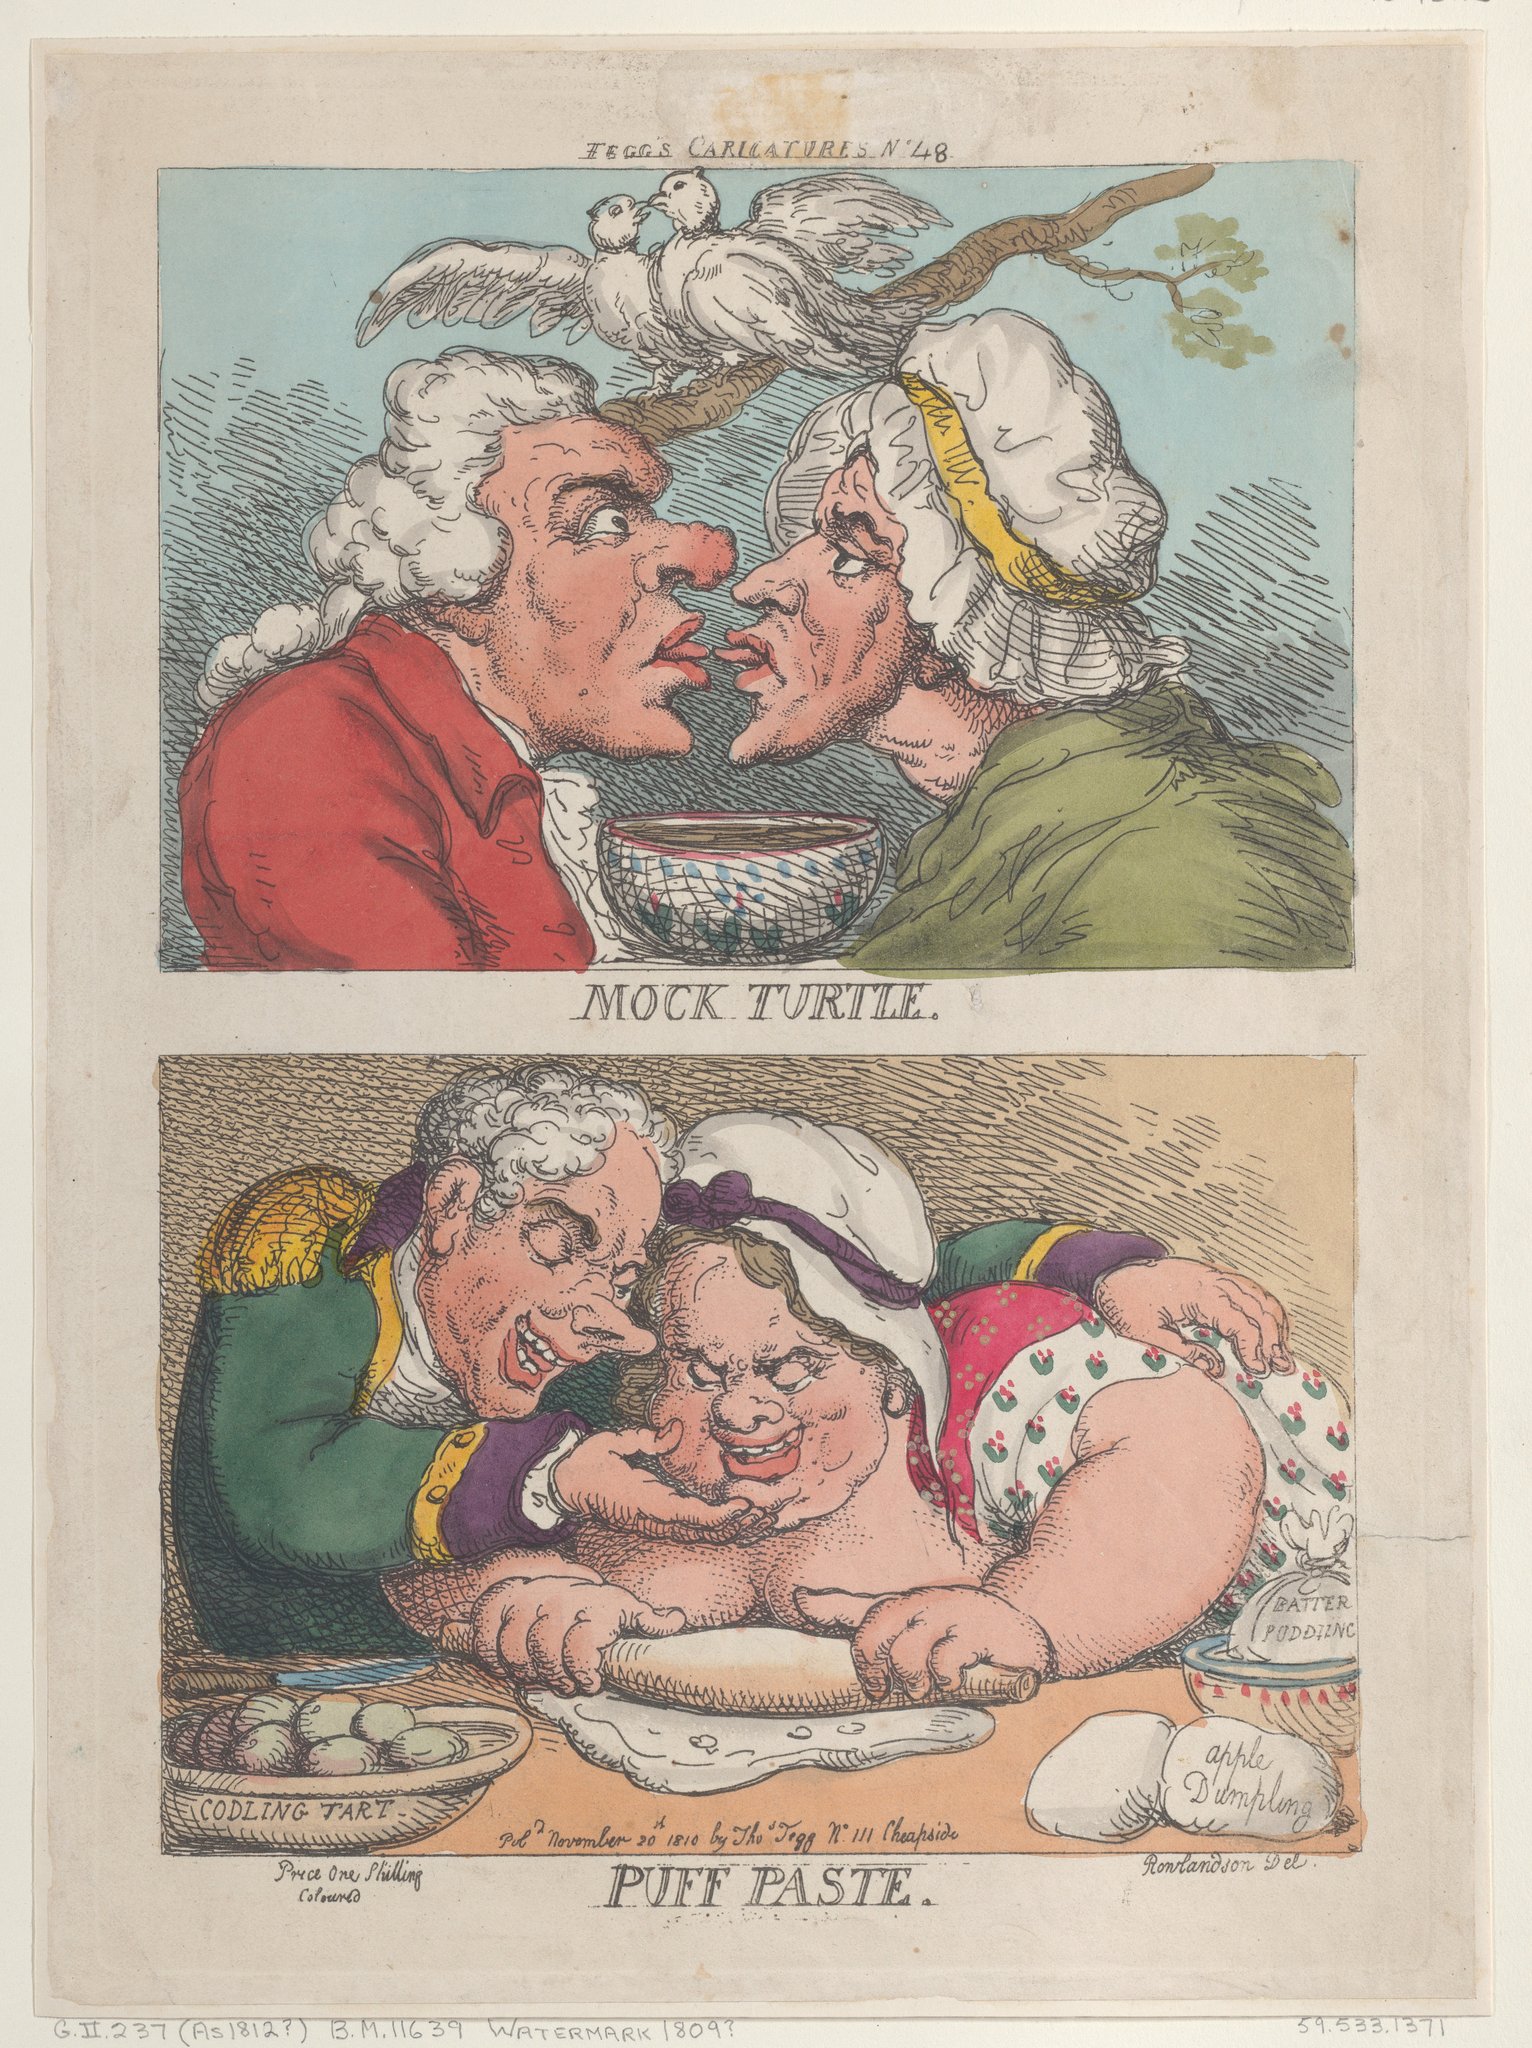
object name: print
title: Mock Turtle; Puff Paste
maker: thomas rowlandson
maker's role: artist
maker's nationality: british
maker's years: 1757-1827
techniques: etching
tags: satire,men,women